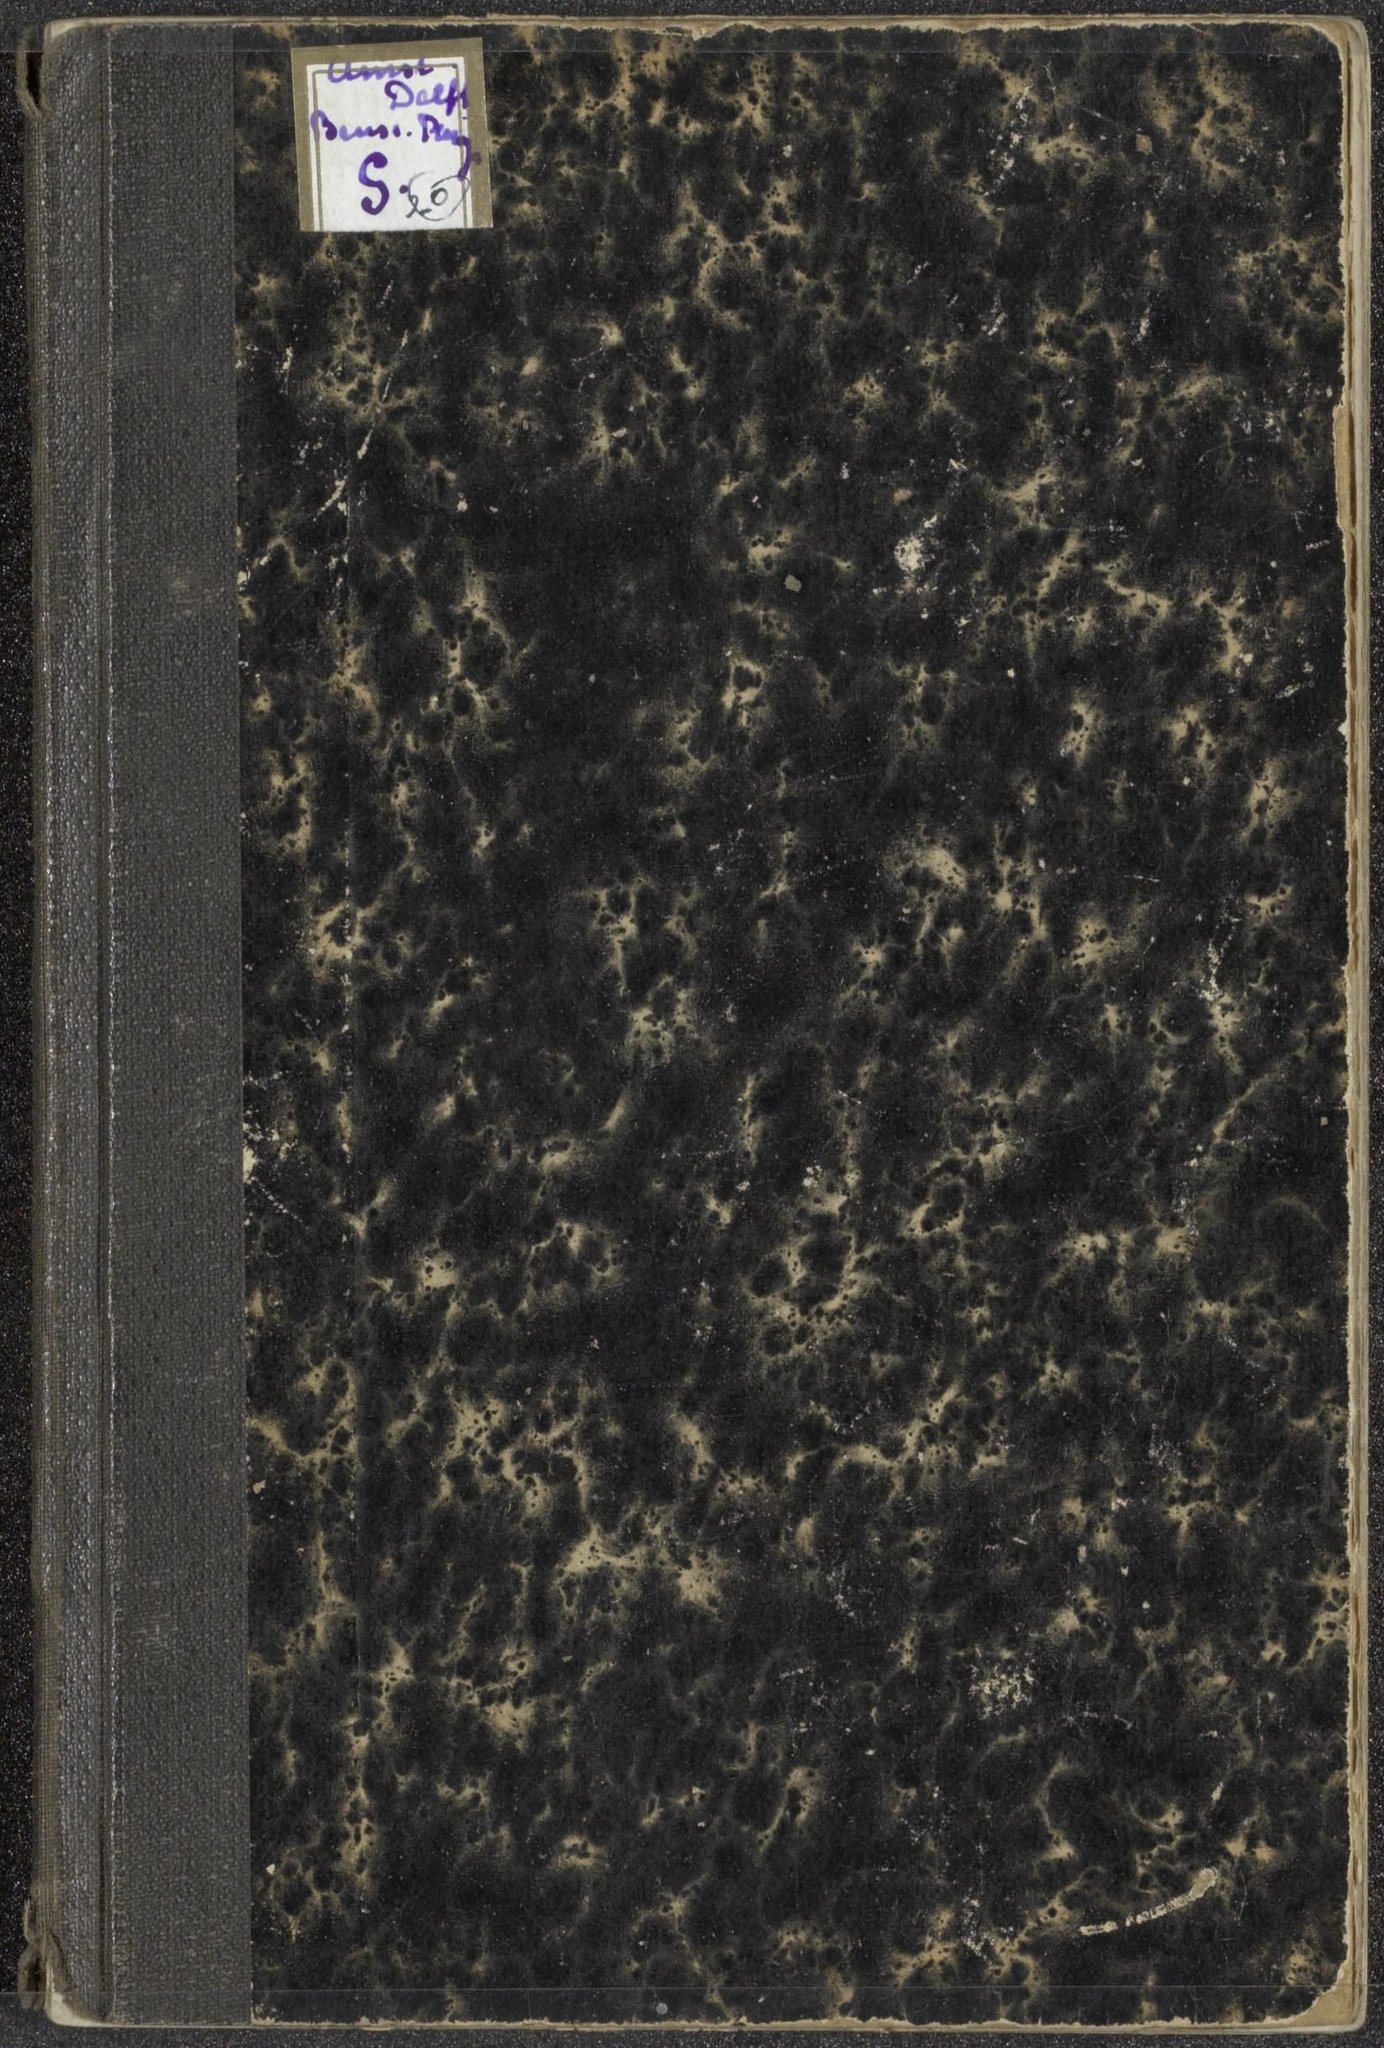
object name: sketchbook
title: Schetsboek met 15 bladen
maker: george hendrik breitner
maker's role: draughtsman, painter, print maker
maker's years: 1857-1923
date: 1891-1894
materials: cardboard, chalk, linen, paper, pencil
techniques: marbling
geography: amsterdam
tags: street, amsterdam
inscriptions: collector's mark: Lugt 2228, annotation: ‘Amst./ Delft/ Bruss./ Parijs/ S./ 26/ Amsterdam’, workshop stamp: Lugt 291d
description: Schetsboek bestaande uit 15 bladen met gezichten te Amsterdam.